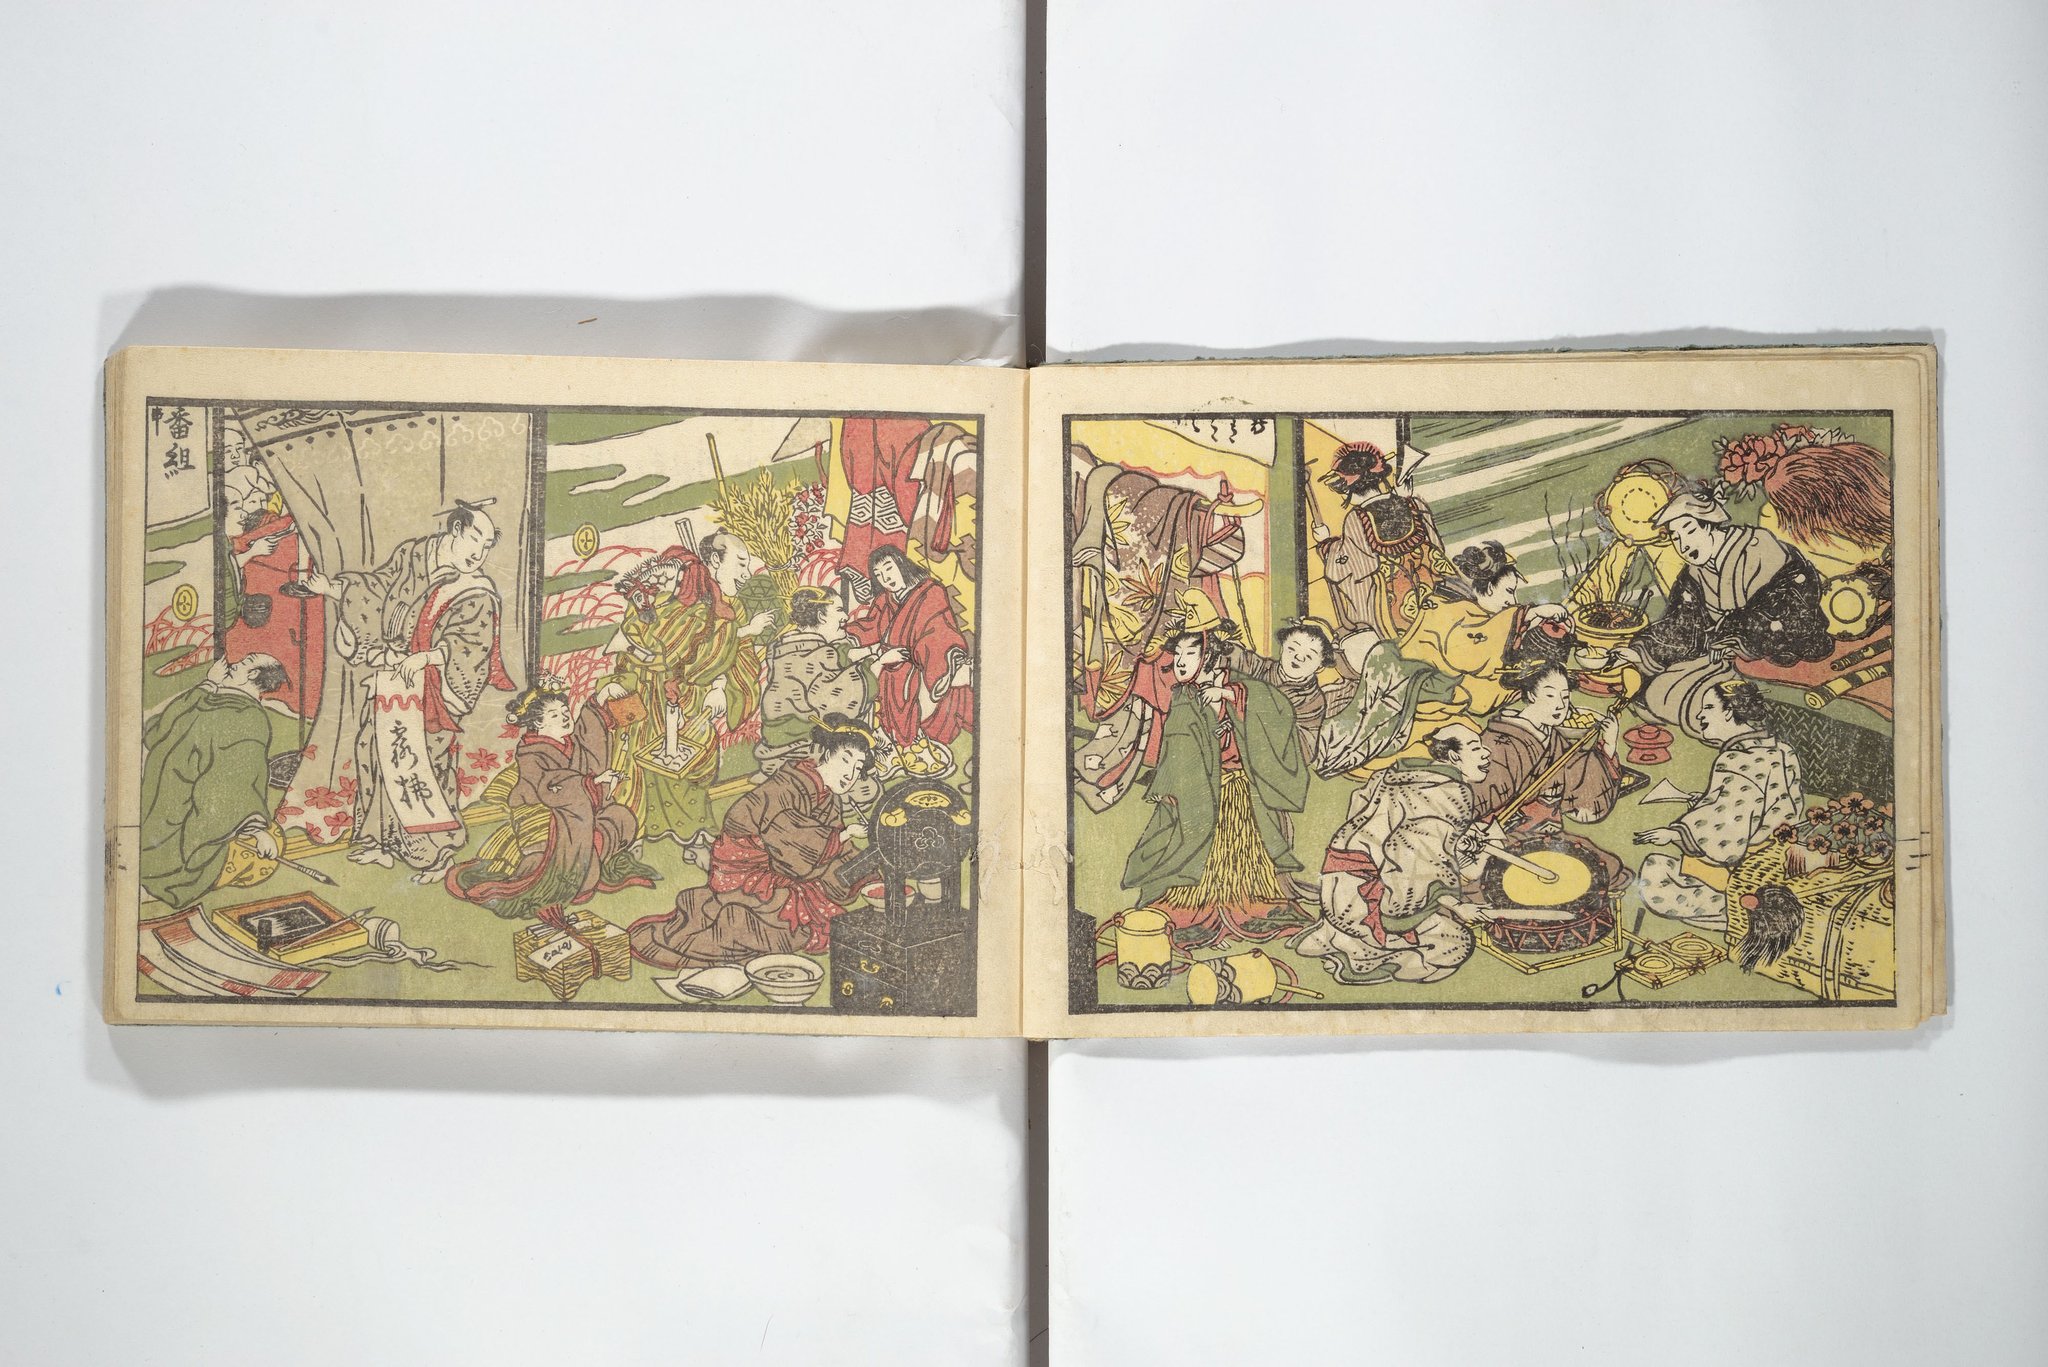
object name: illustrated book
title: Teach Yourself How to Dance (Odori hitori keiko) 踊独稽古; 酒宴即興踊独稽古(しゅえん そっきょう おどりひとりげいこ)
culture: japanese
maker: sanshōsai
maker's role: artist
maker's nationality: japanese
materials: ink, paper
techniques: woodblock print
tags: musical instruments,men,women,dancing